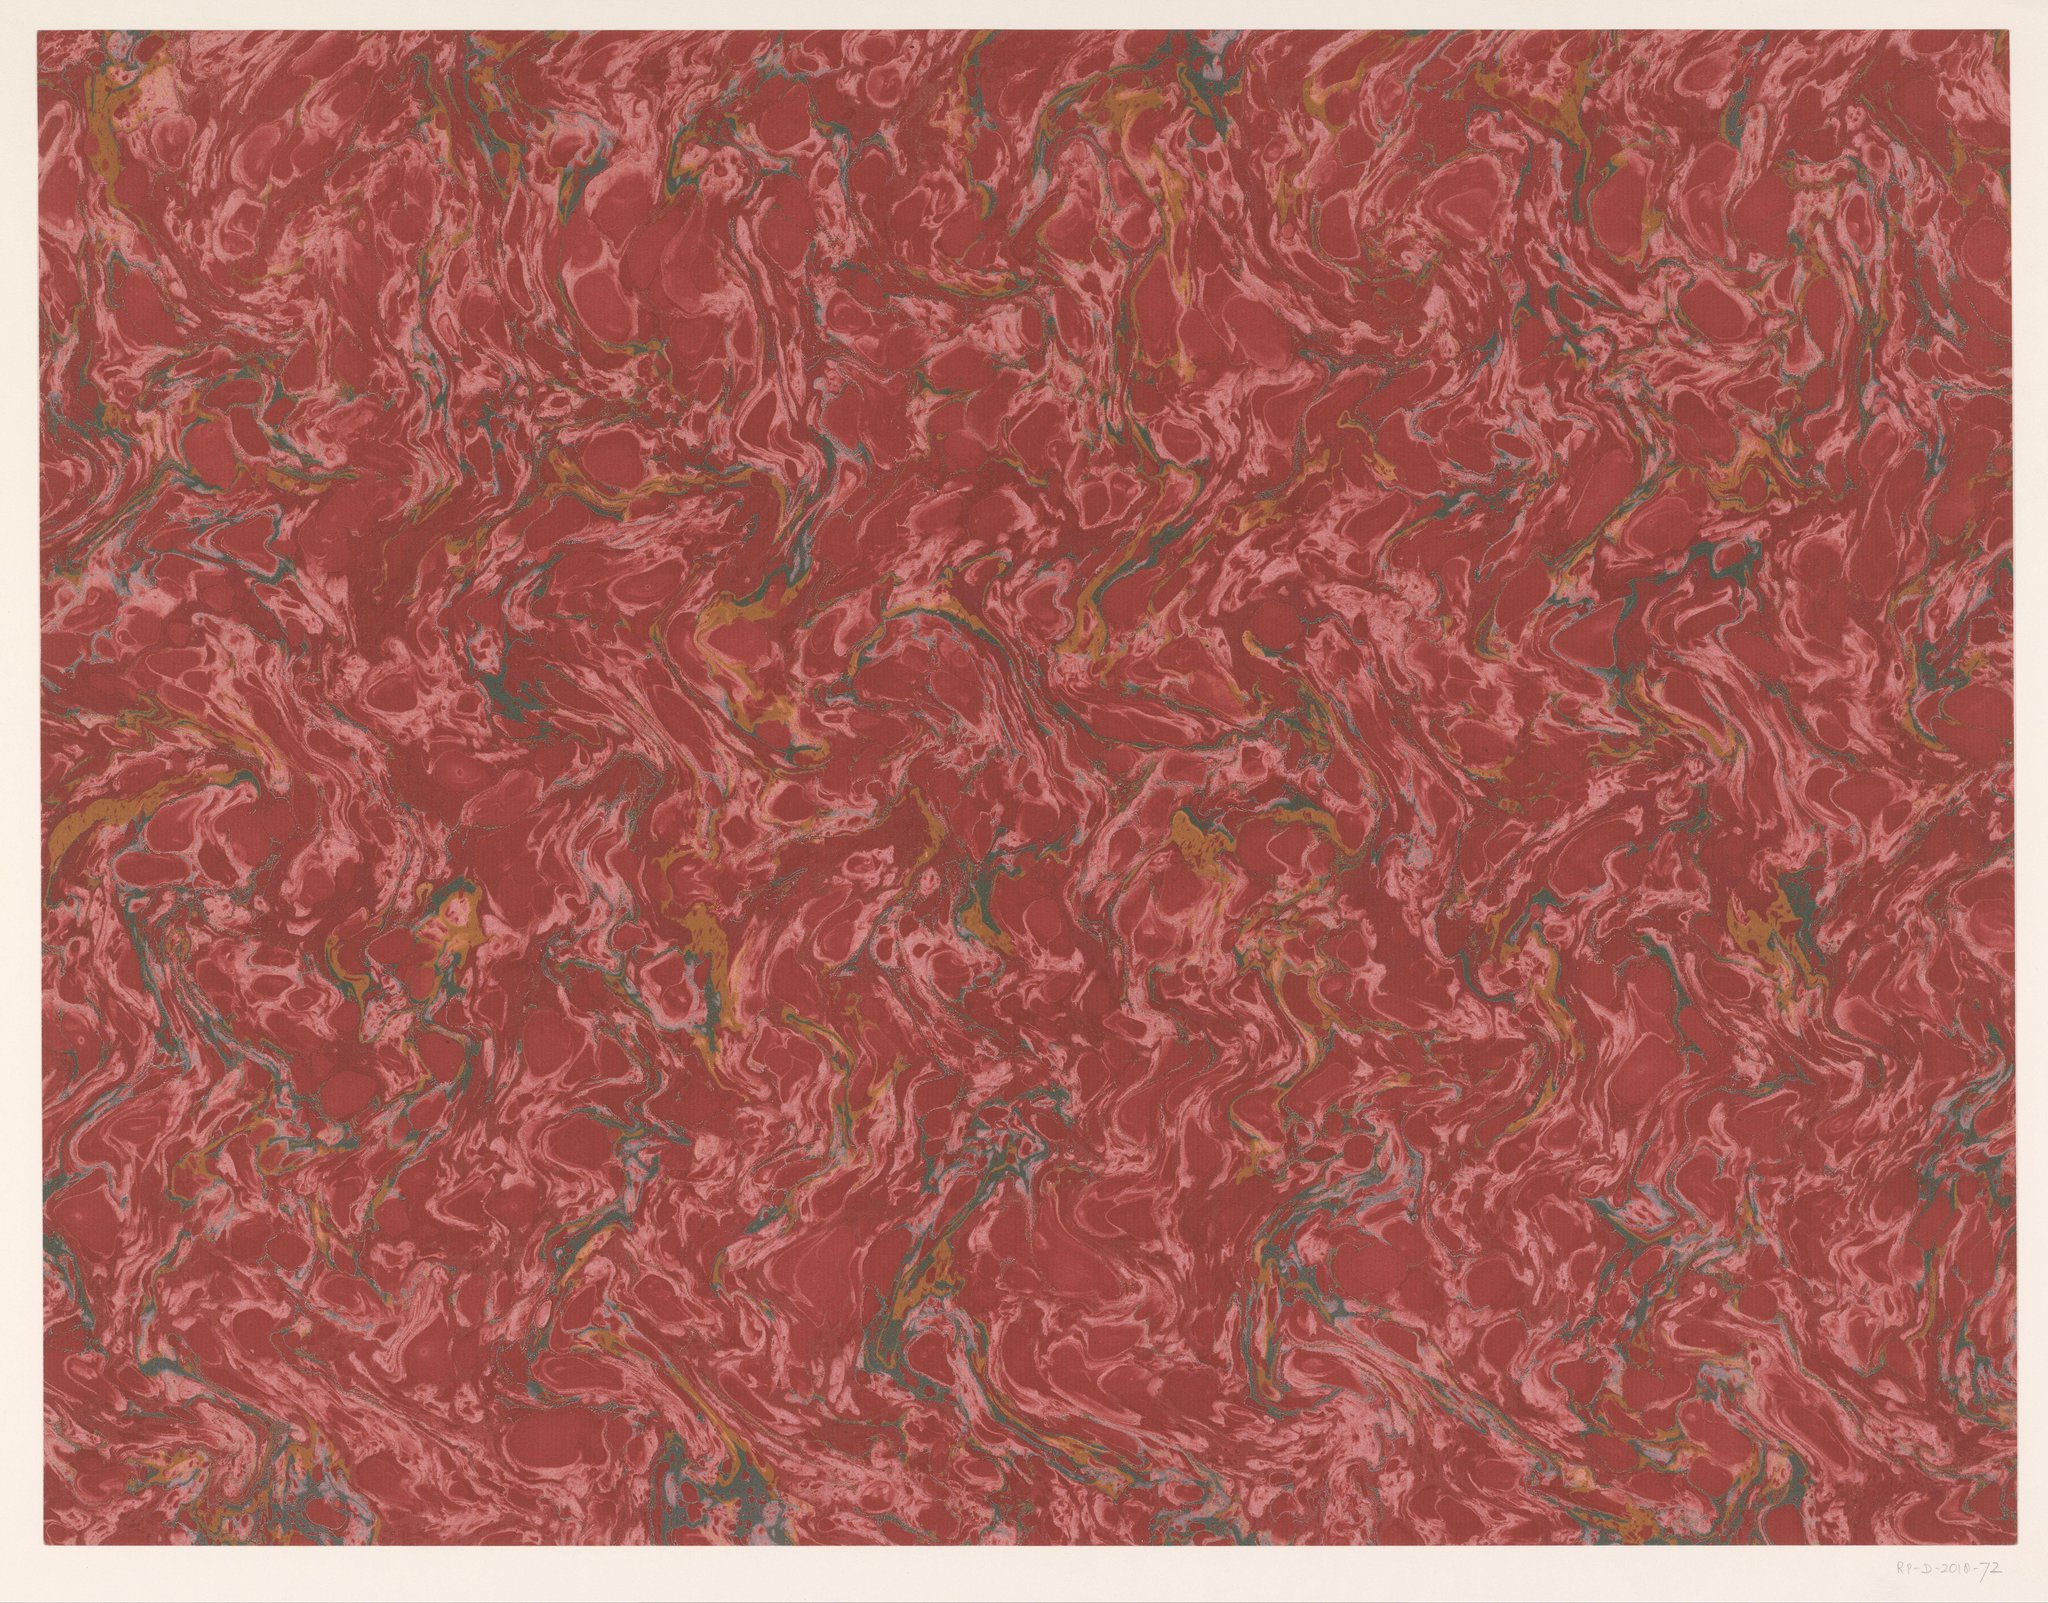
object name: marbled paper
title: Fantasiemarmer in rood, groen en geelgroen en glitter op roze papier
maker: Anonymous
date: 1900-2000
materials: glitter, paint, paper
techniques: marbled paper